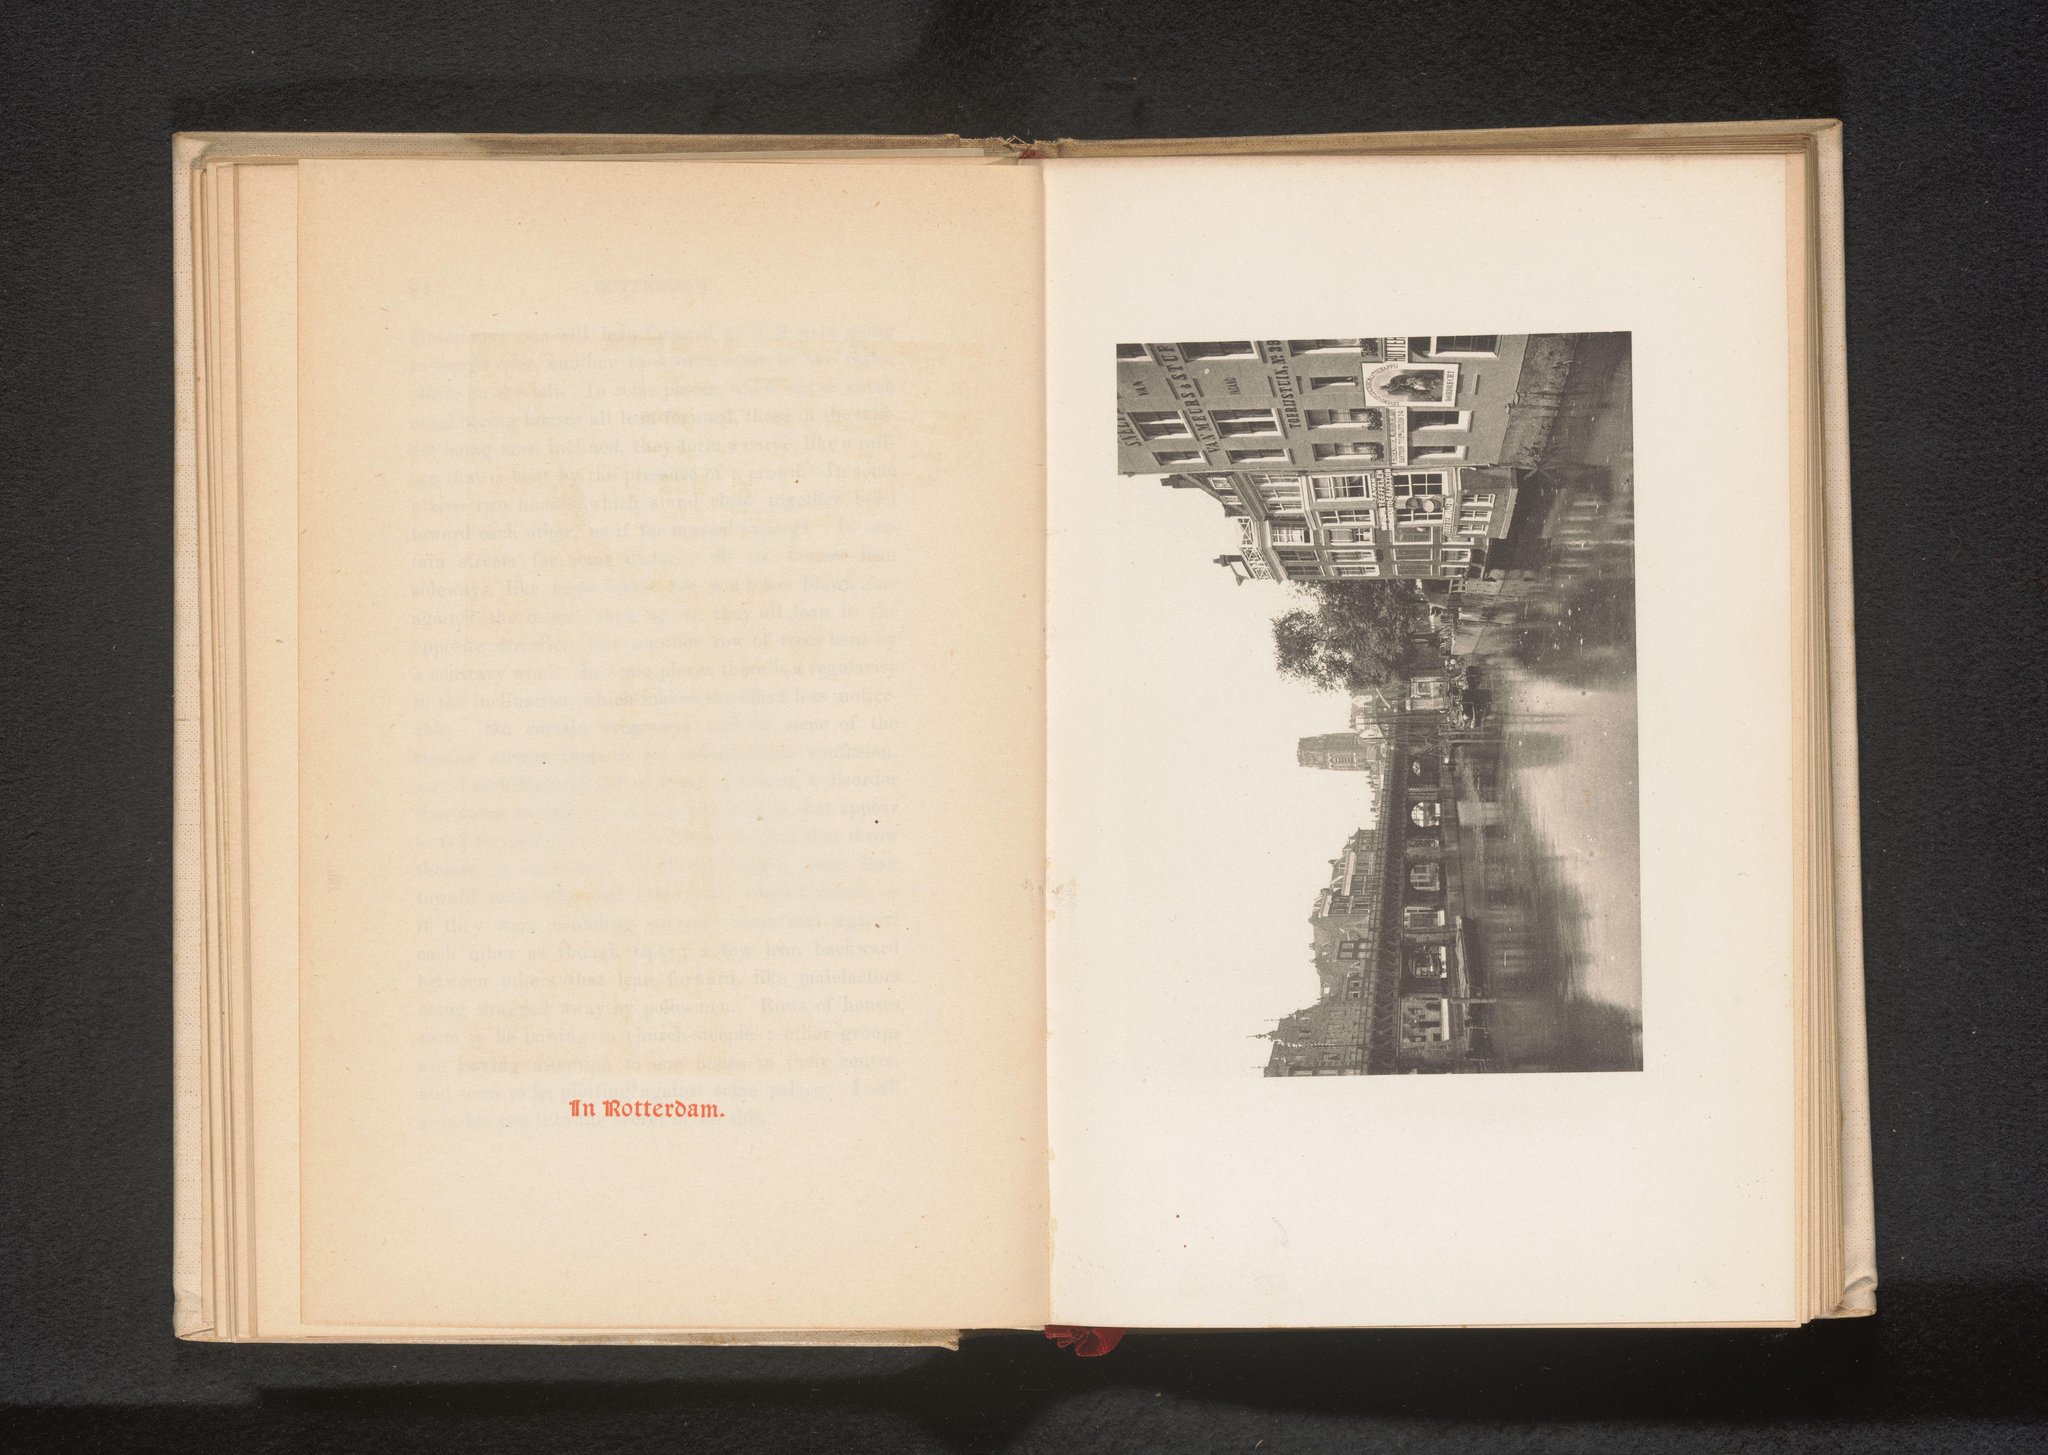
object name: page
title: Gezicht op de Kolk te Rotterdam, met op de achtergrond de Sint-Laurenskerk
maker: charles l. mitchell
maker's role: fotograaf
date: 1884-1894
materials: paper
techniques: photoaquatint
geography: rotterdam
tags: river, church (exterior)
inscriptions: title: ‘In Rotterdam.’